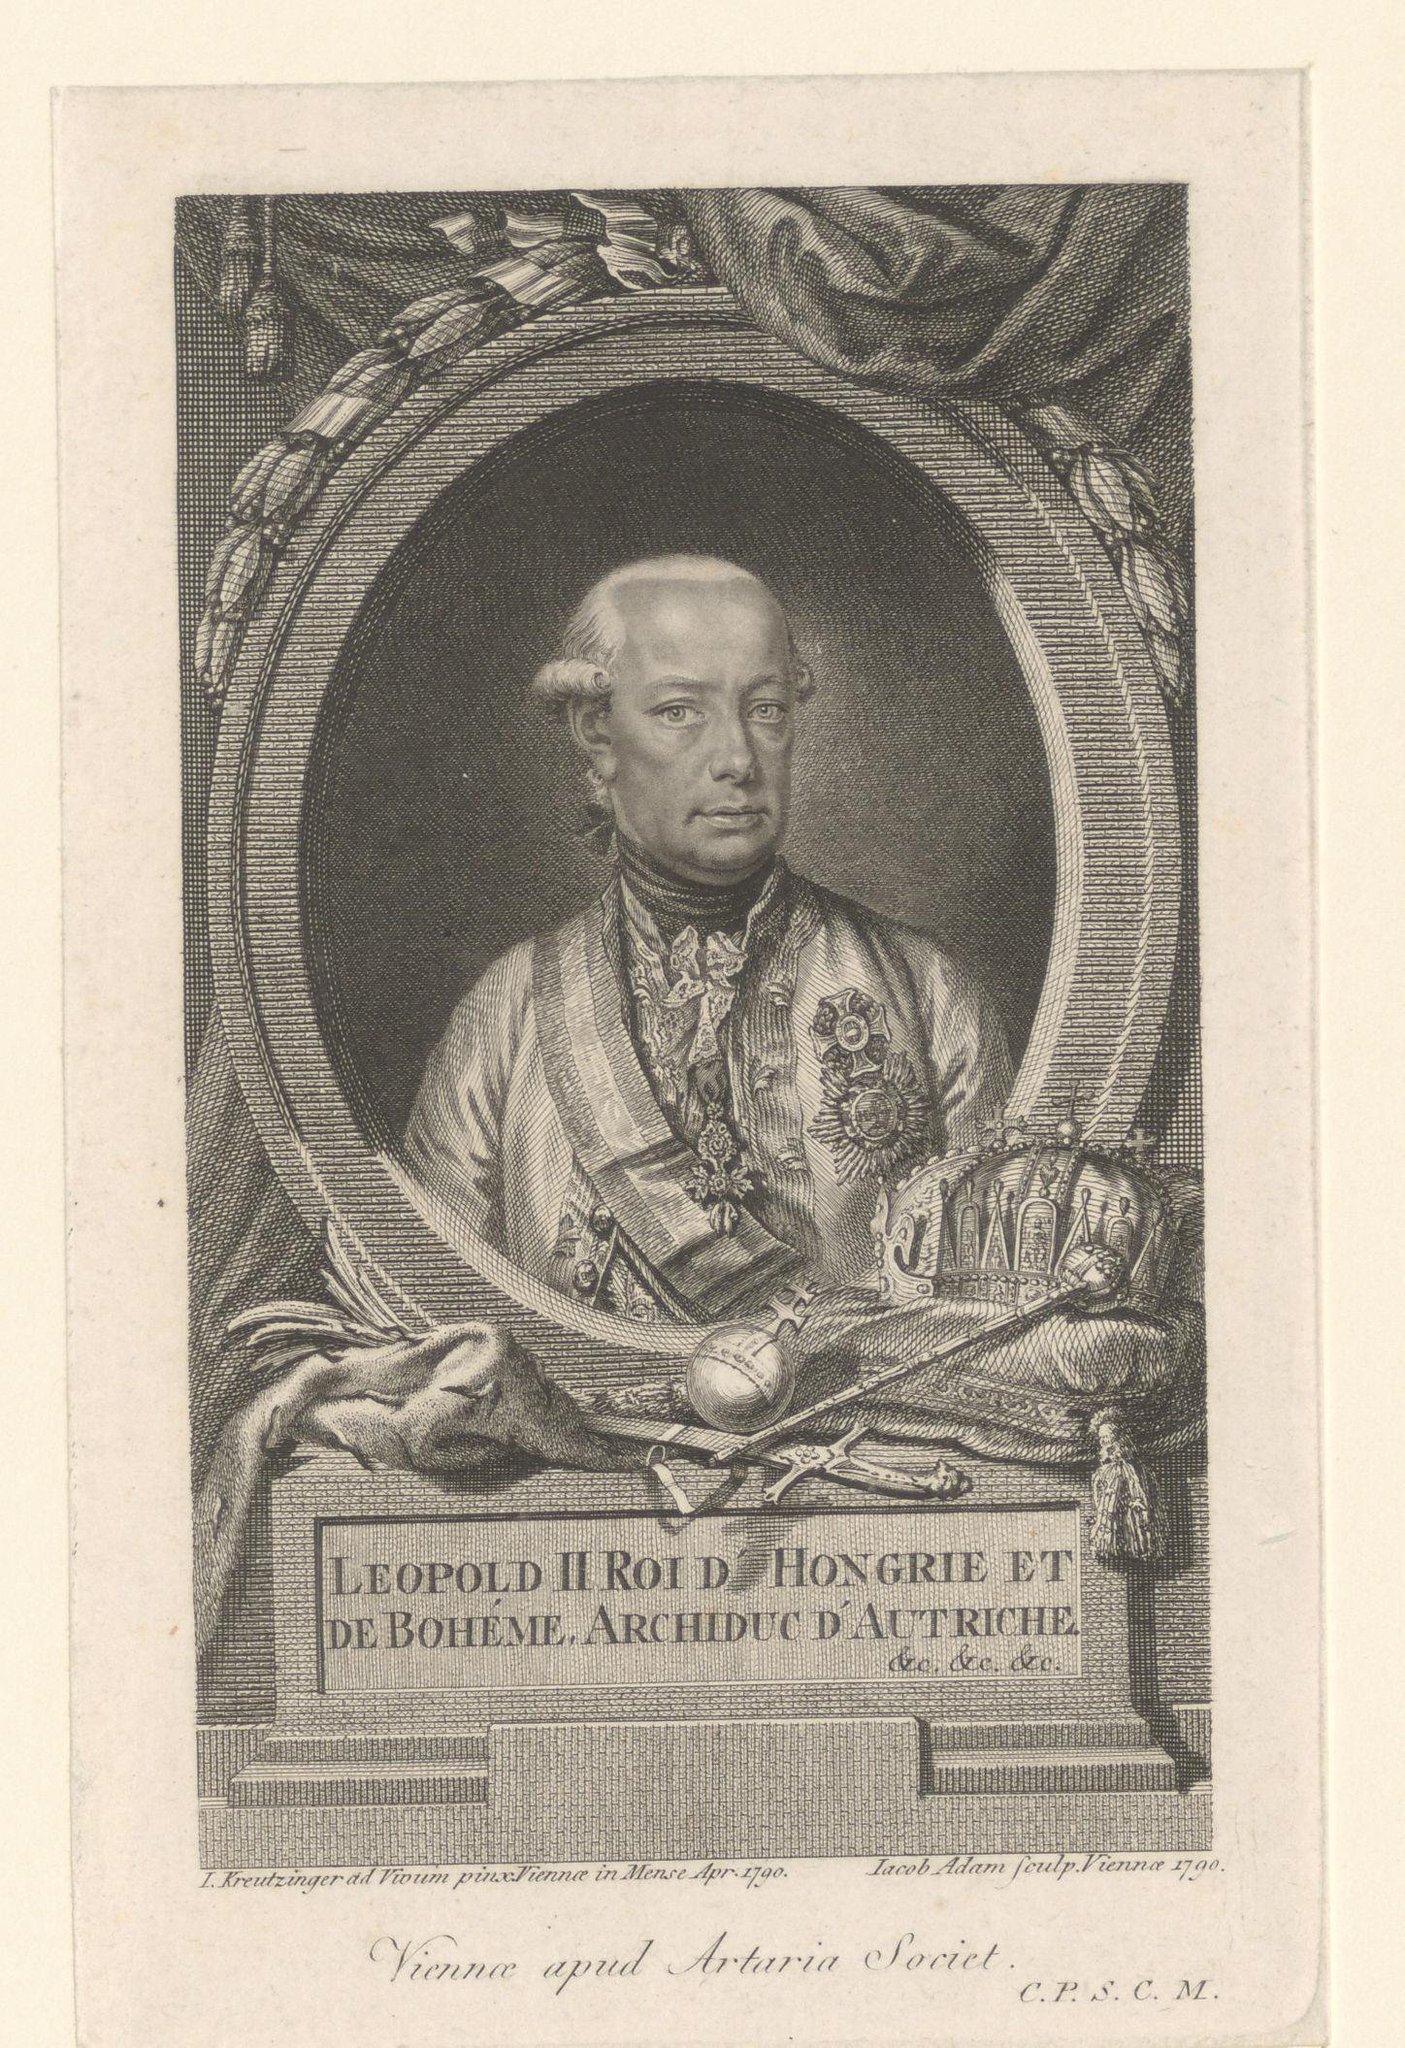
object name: print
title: Leopold II Roi d'Hongrie et de Bohéme, Archicduc d'Autriche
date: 1790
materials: paper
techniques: etching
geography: vienna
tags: vienna, leopold ii (keizer van oostenrijk), historical persons, insignia and symbols of sovereignty (crown, diadem, sceptre, orb, seal, standard, cloak, pectoral)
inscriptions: collector's mark: Lugt 2228